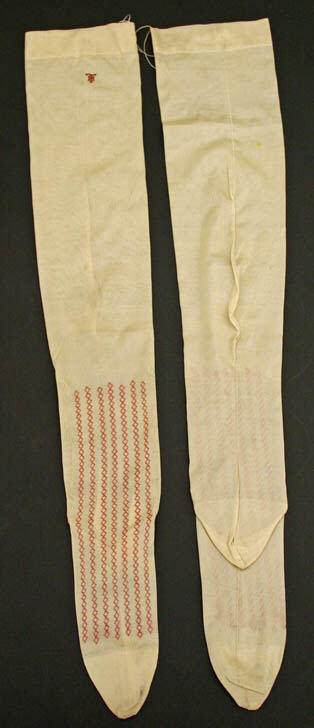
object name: stocking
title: Stockings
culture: french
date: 1801-1900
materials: silk